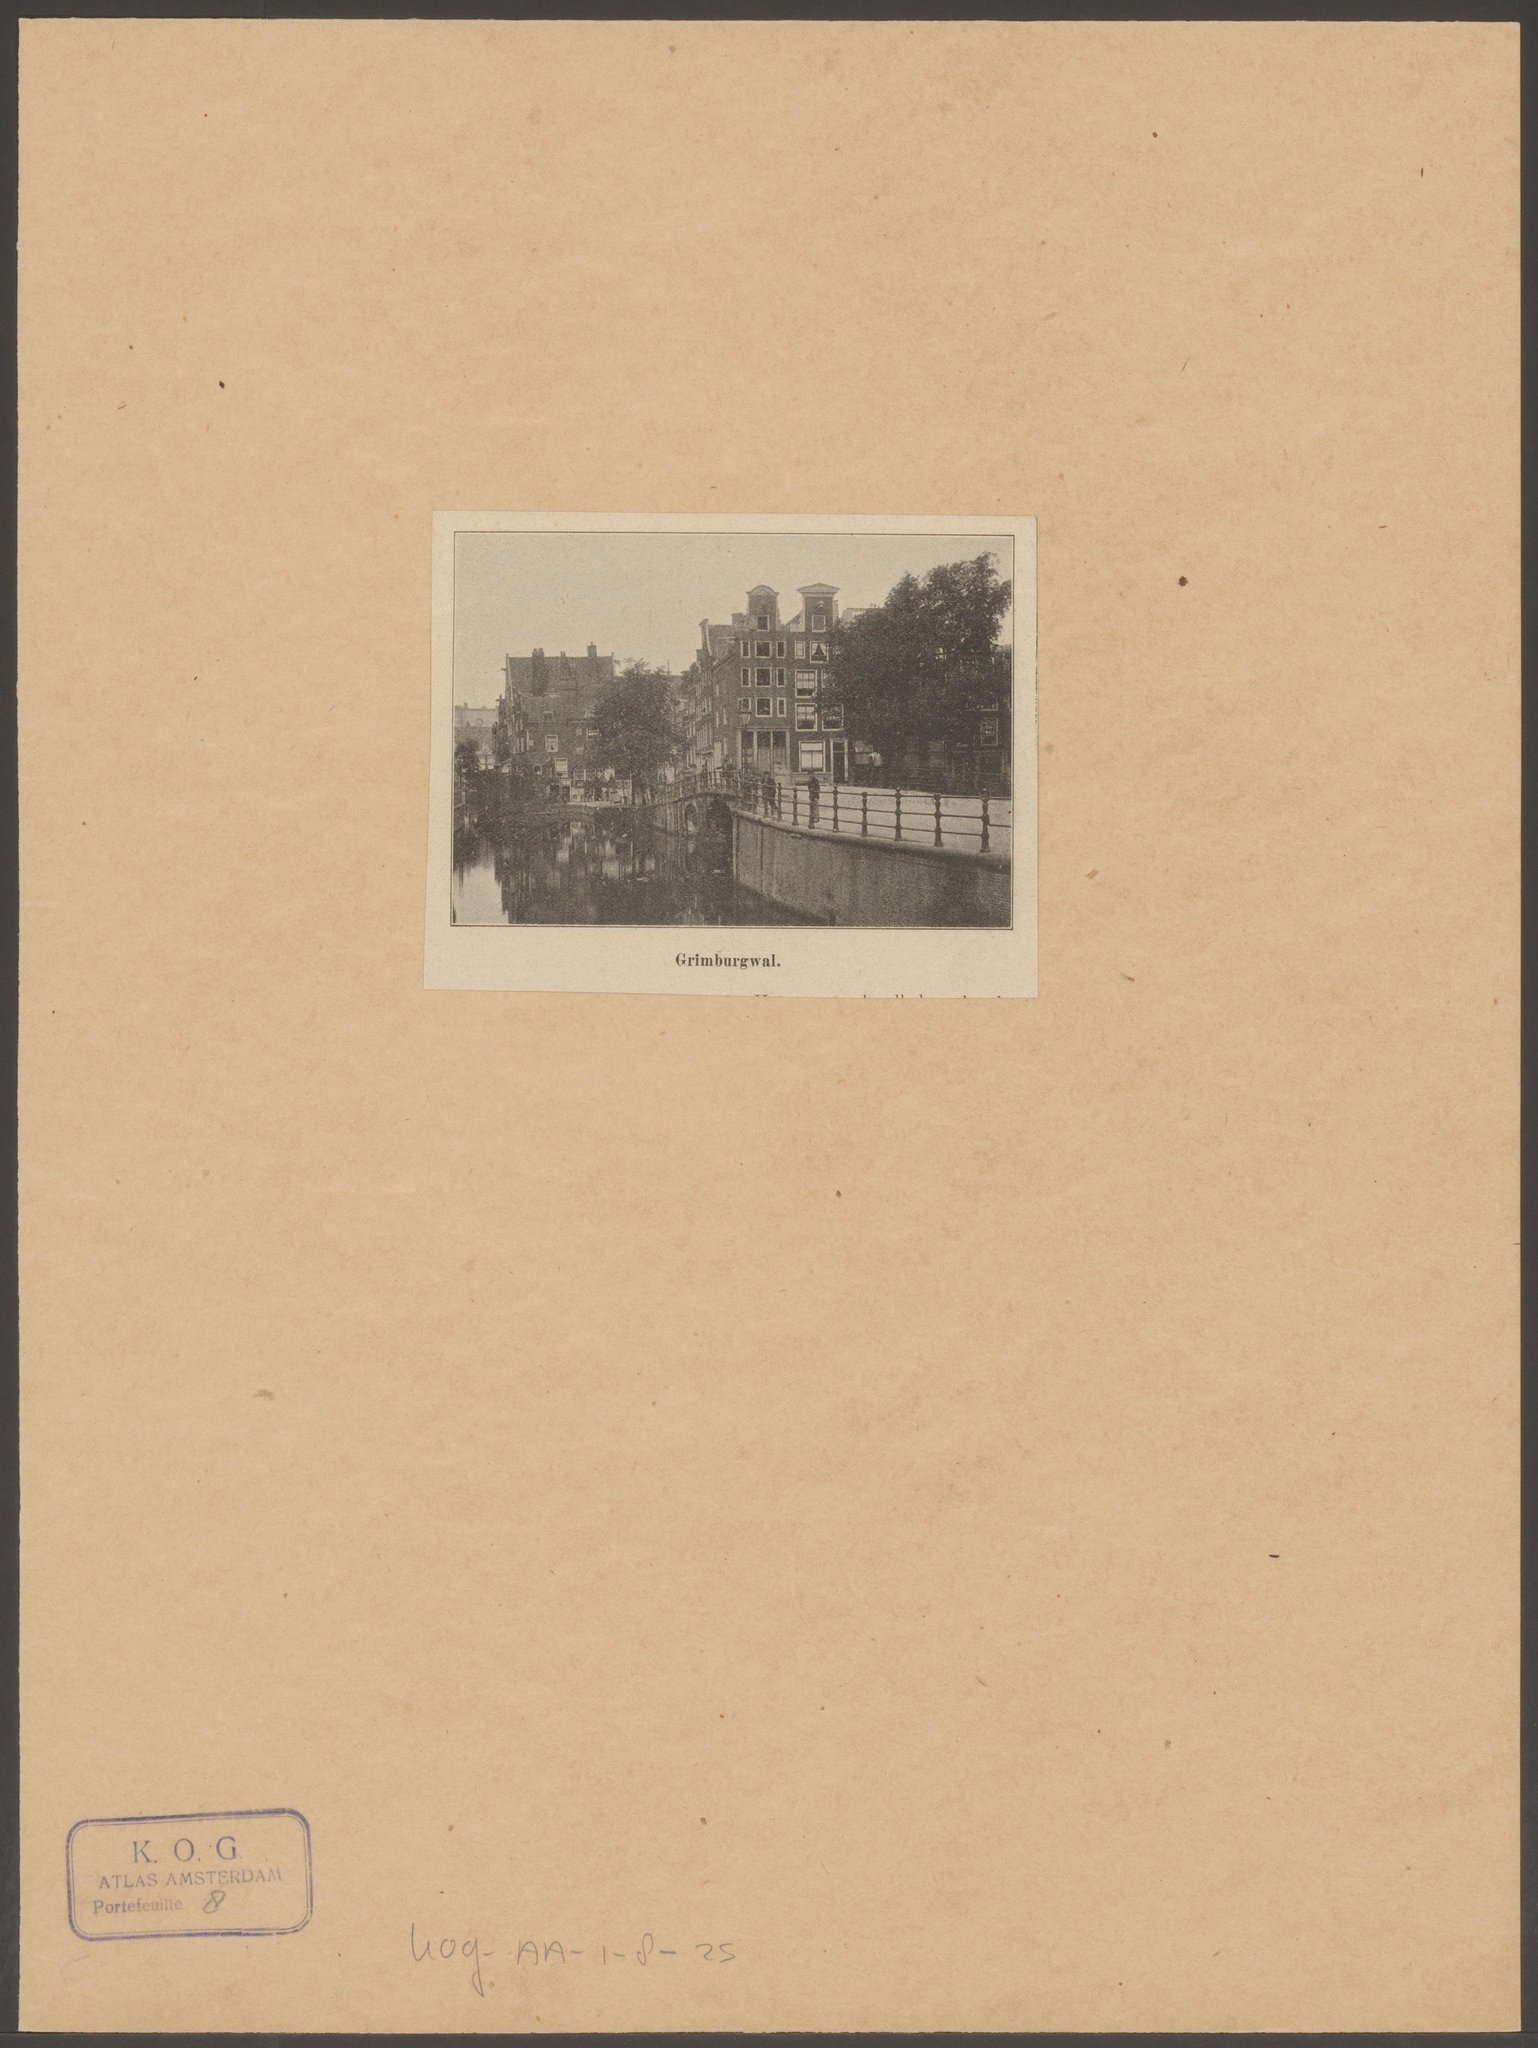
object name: photomechanical print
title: Gezicht op de Grimburgwal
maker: Anonymous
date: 1882-1950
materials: paper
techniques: letterpress printing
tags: city-view in general; 'veduta', canal, bridge in city across river, canal, etc.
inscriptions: collector's mark: ‘8’ Lugt 1641b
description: Onderwerpsrubriek binnen de Atlas Amsterdam: Galerij Paleis voor Volksvlijt, Gebed zonder end, Geldersche Kade, Gravenstraat, Grimburgwal, Grimnessesluis, Groeneburgwal.